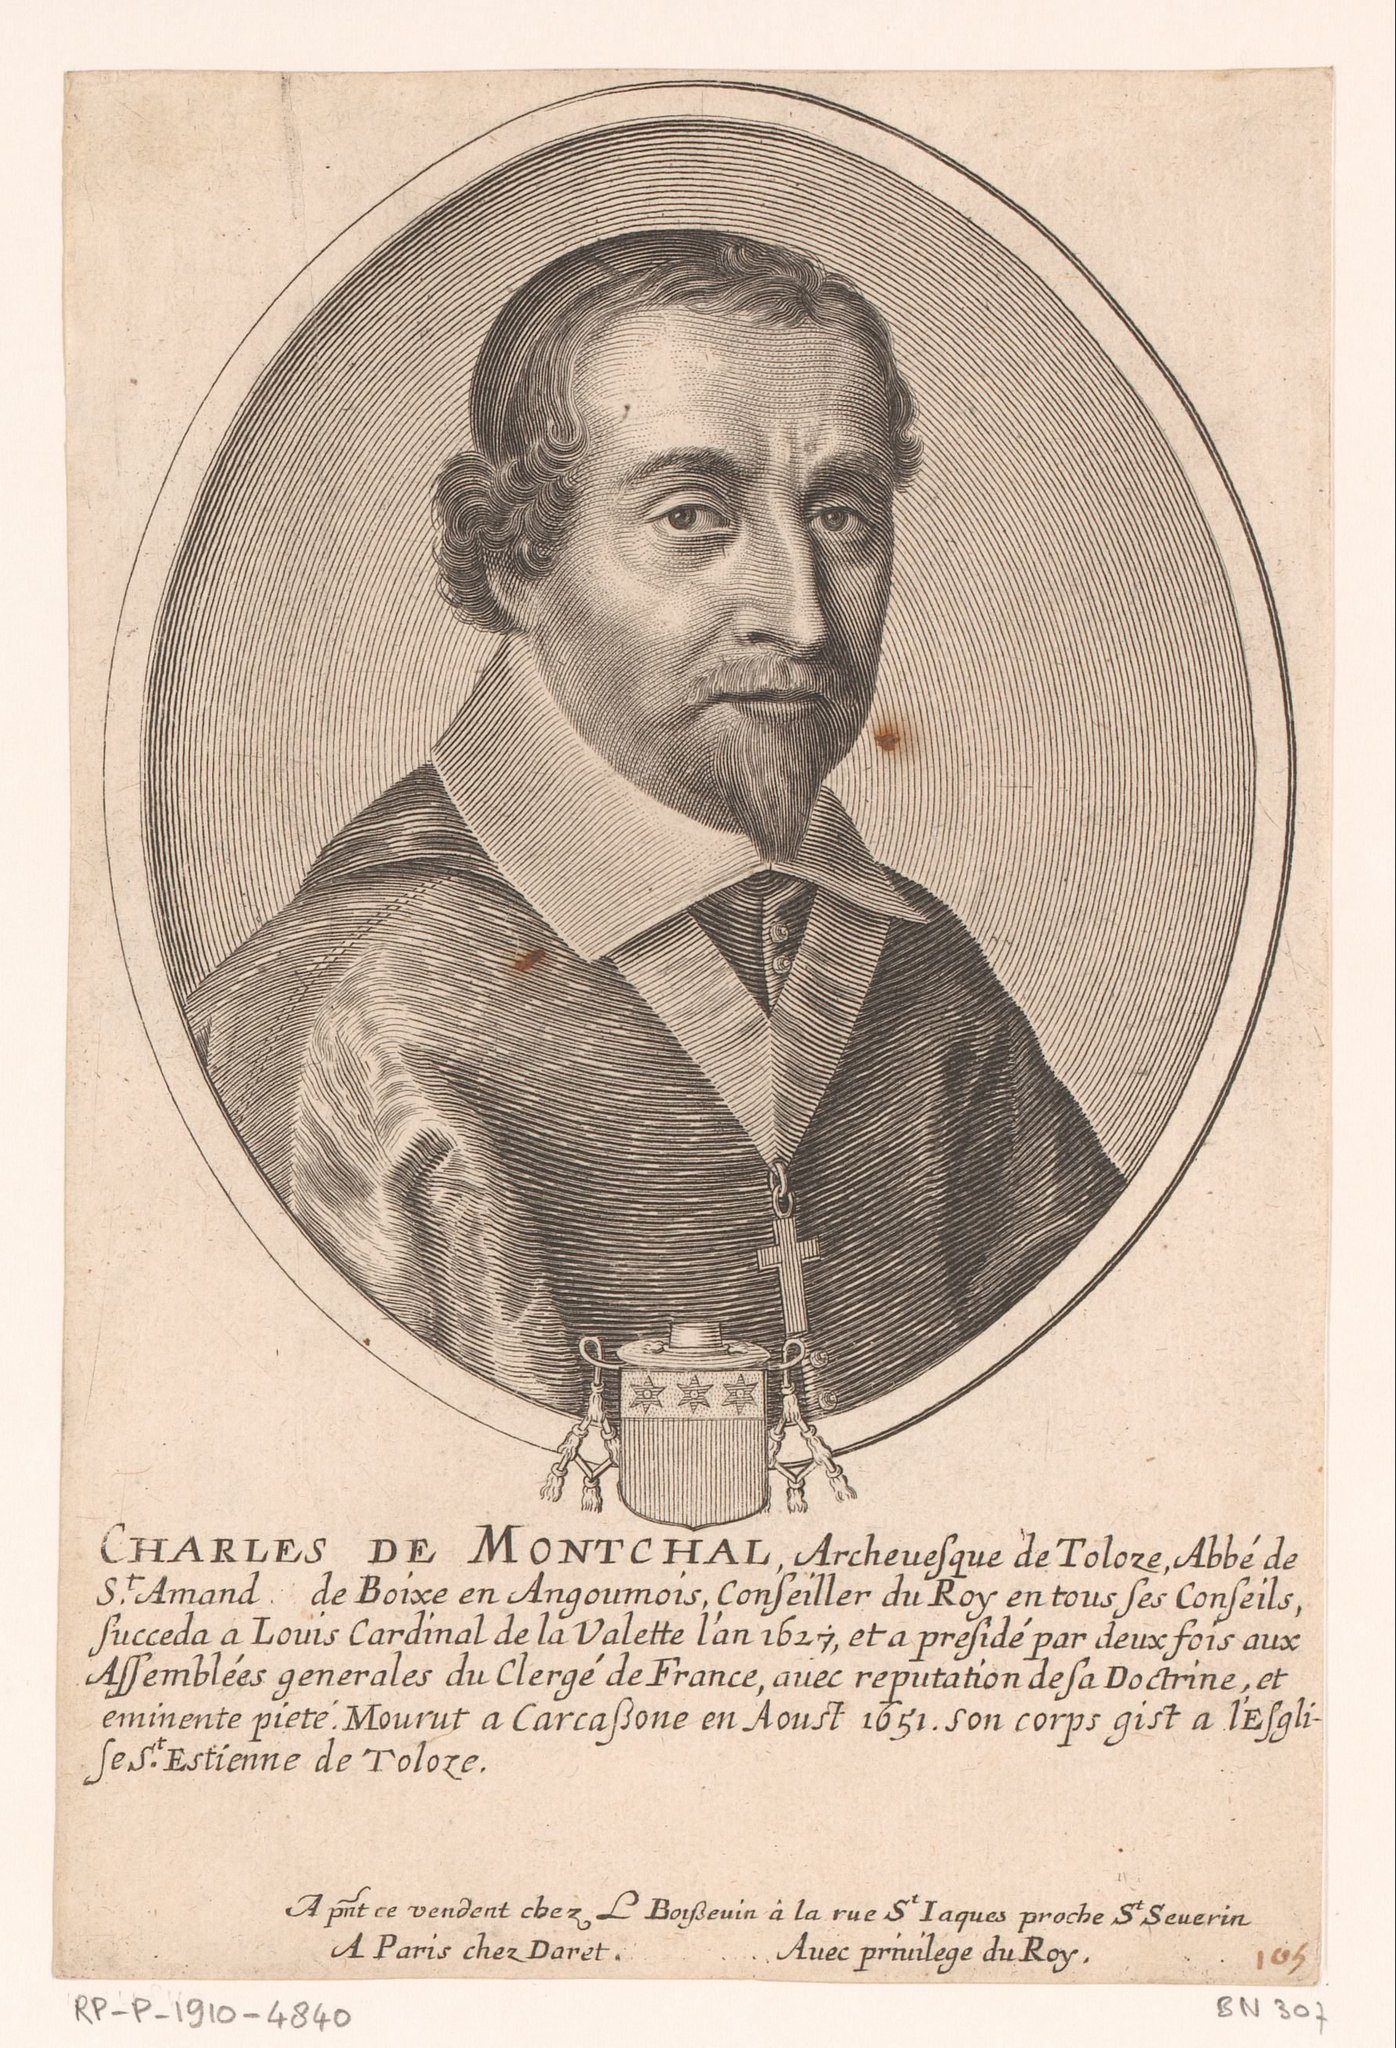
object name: print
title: Portretten van bekende historische figuren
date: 1652-1656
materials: paper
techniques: engraving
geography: france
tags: historical persons, armorial bearing, heraldry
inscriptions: collector's mark: Lugt 2228, number: ‘105’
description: Maakt deel uit van een serie portretten getiteld 'Tableaux historiques ou sont gravez les Illustres François et Etrangiers de l'un et l'autre sexe (...)', voor het eerst uitgegeven in 1652 door Daret. Een tweede staat werd uitgegeven door Boissevin en een derde door Jollain.